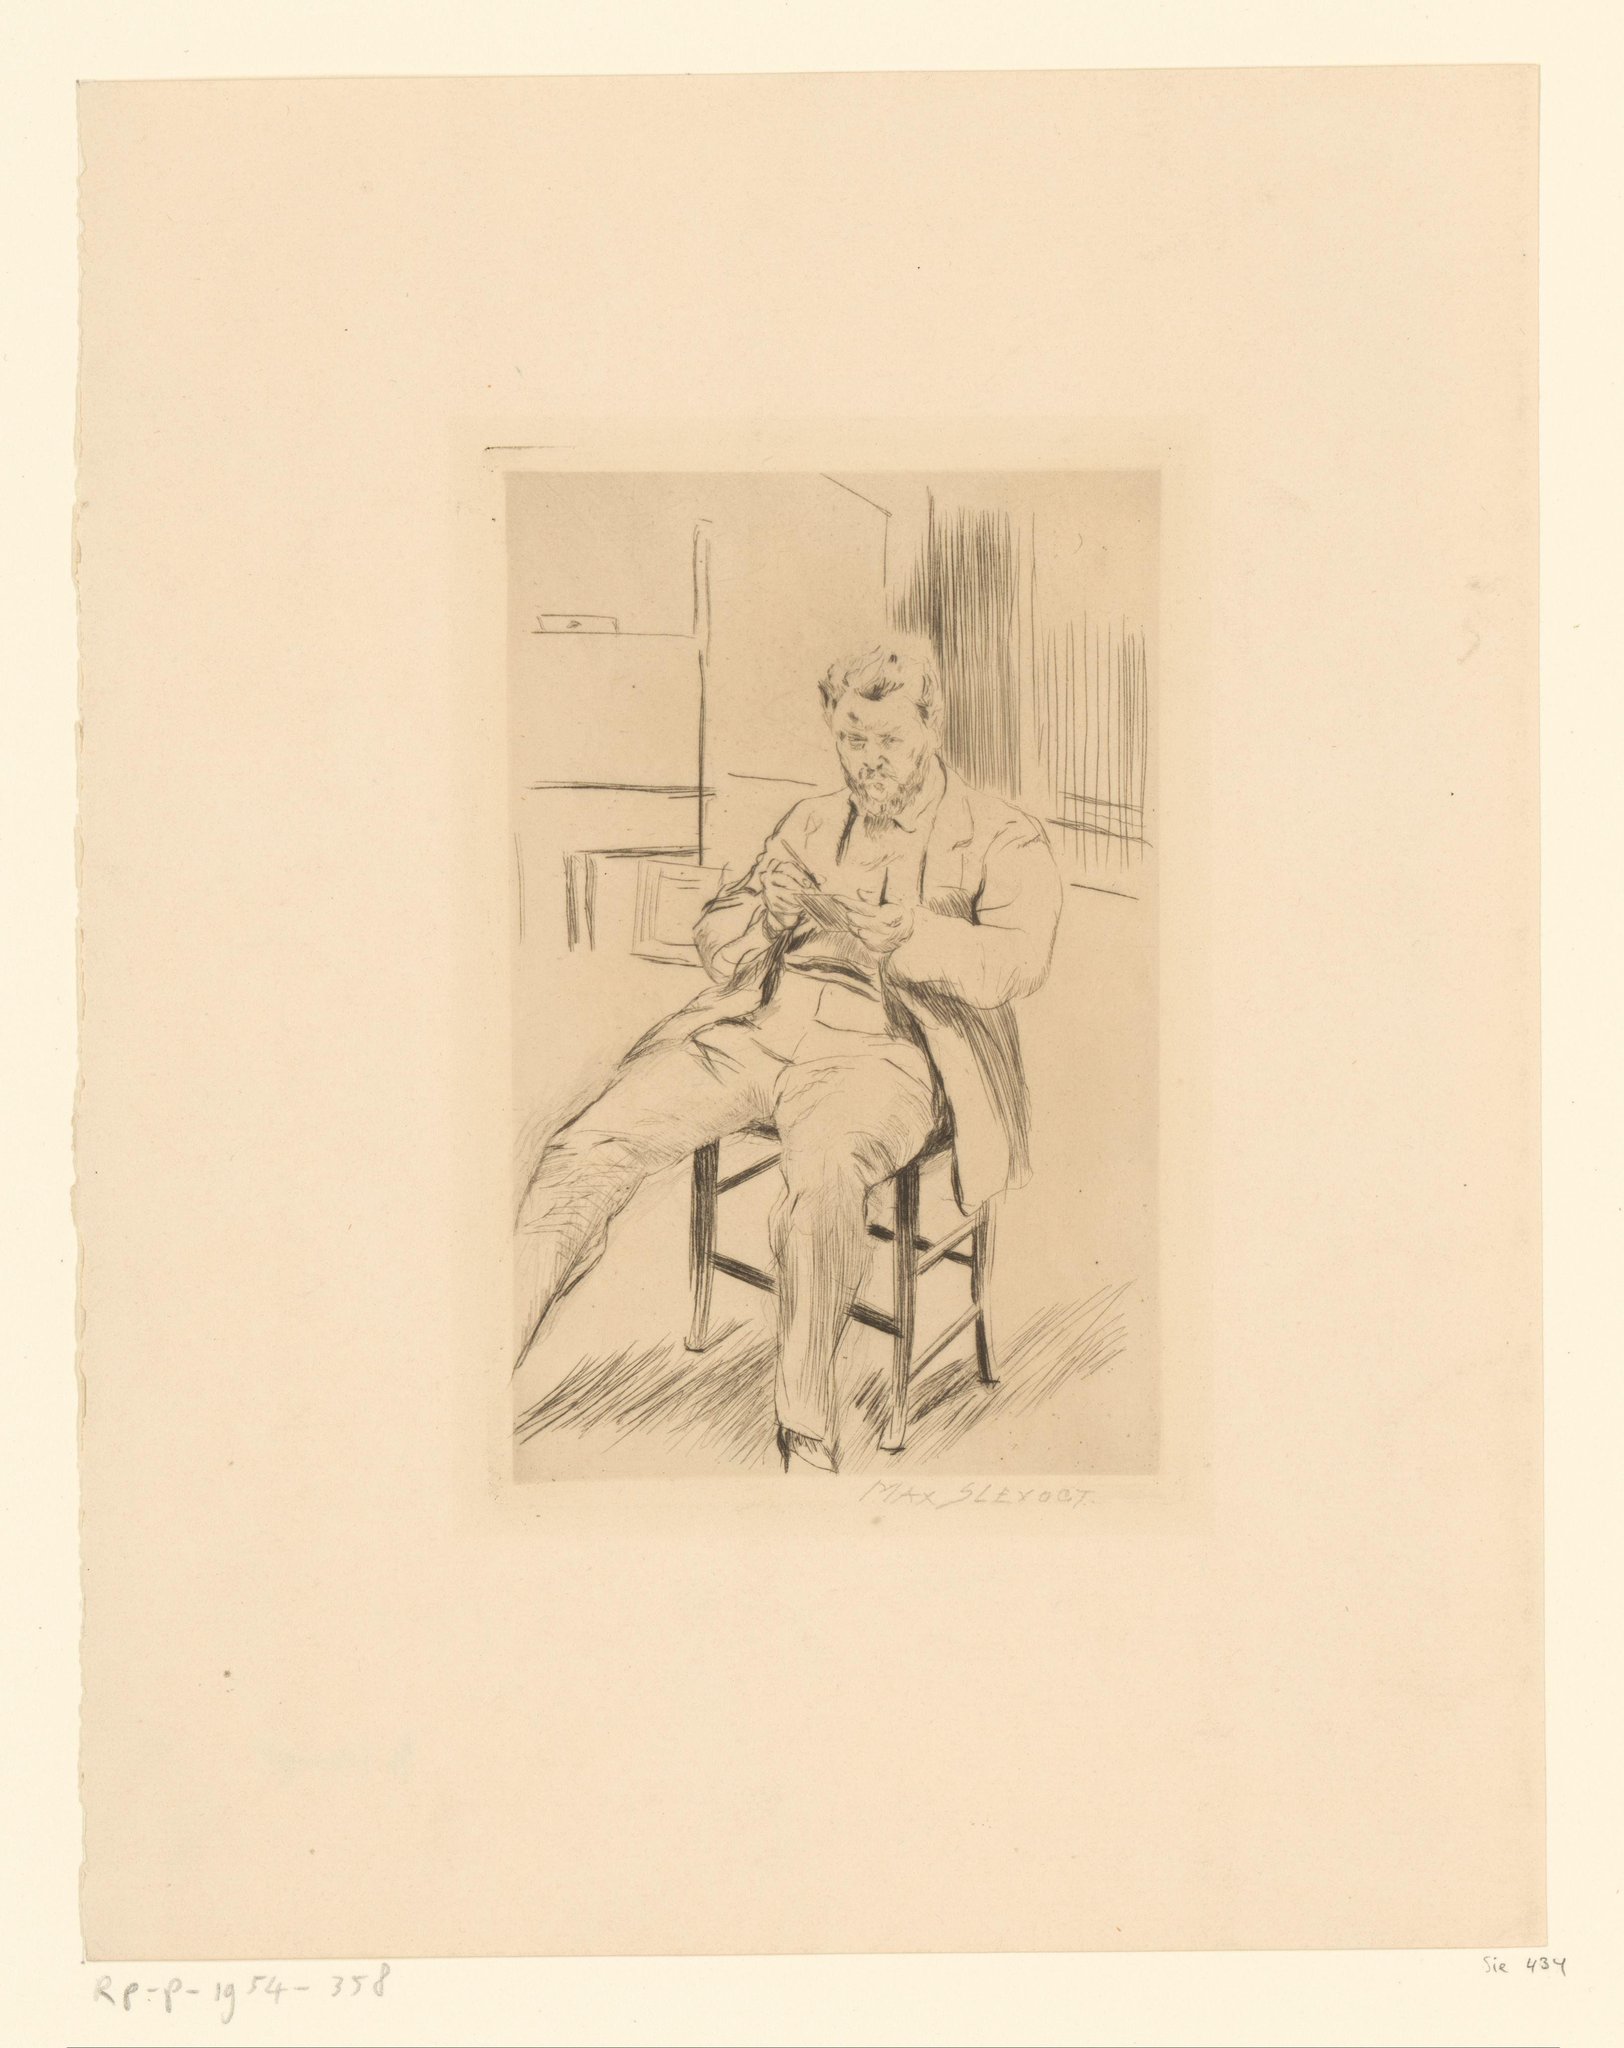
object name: print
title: Zelfportret, graverend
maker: max slevogt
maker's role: print maker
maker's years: 1868-1932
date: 1911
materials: paper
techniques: drypoint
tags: print maker, max slevogt, portrait, self-portrait of artist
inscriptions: collector's mark: Lugt 2228